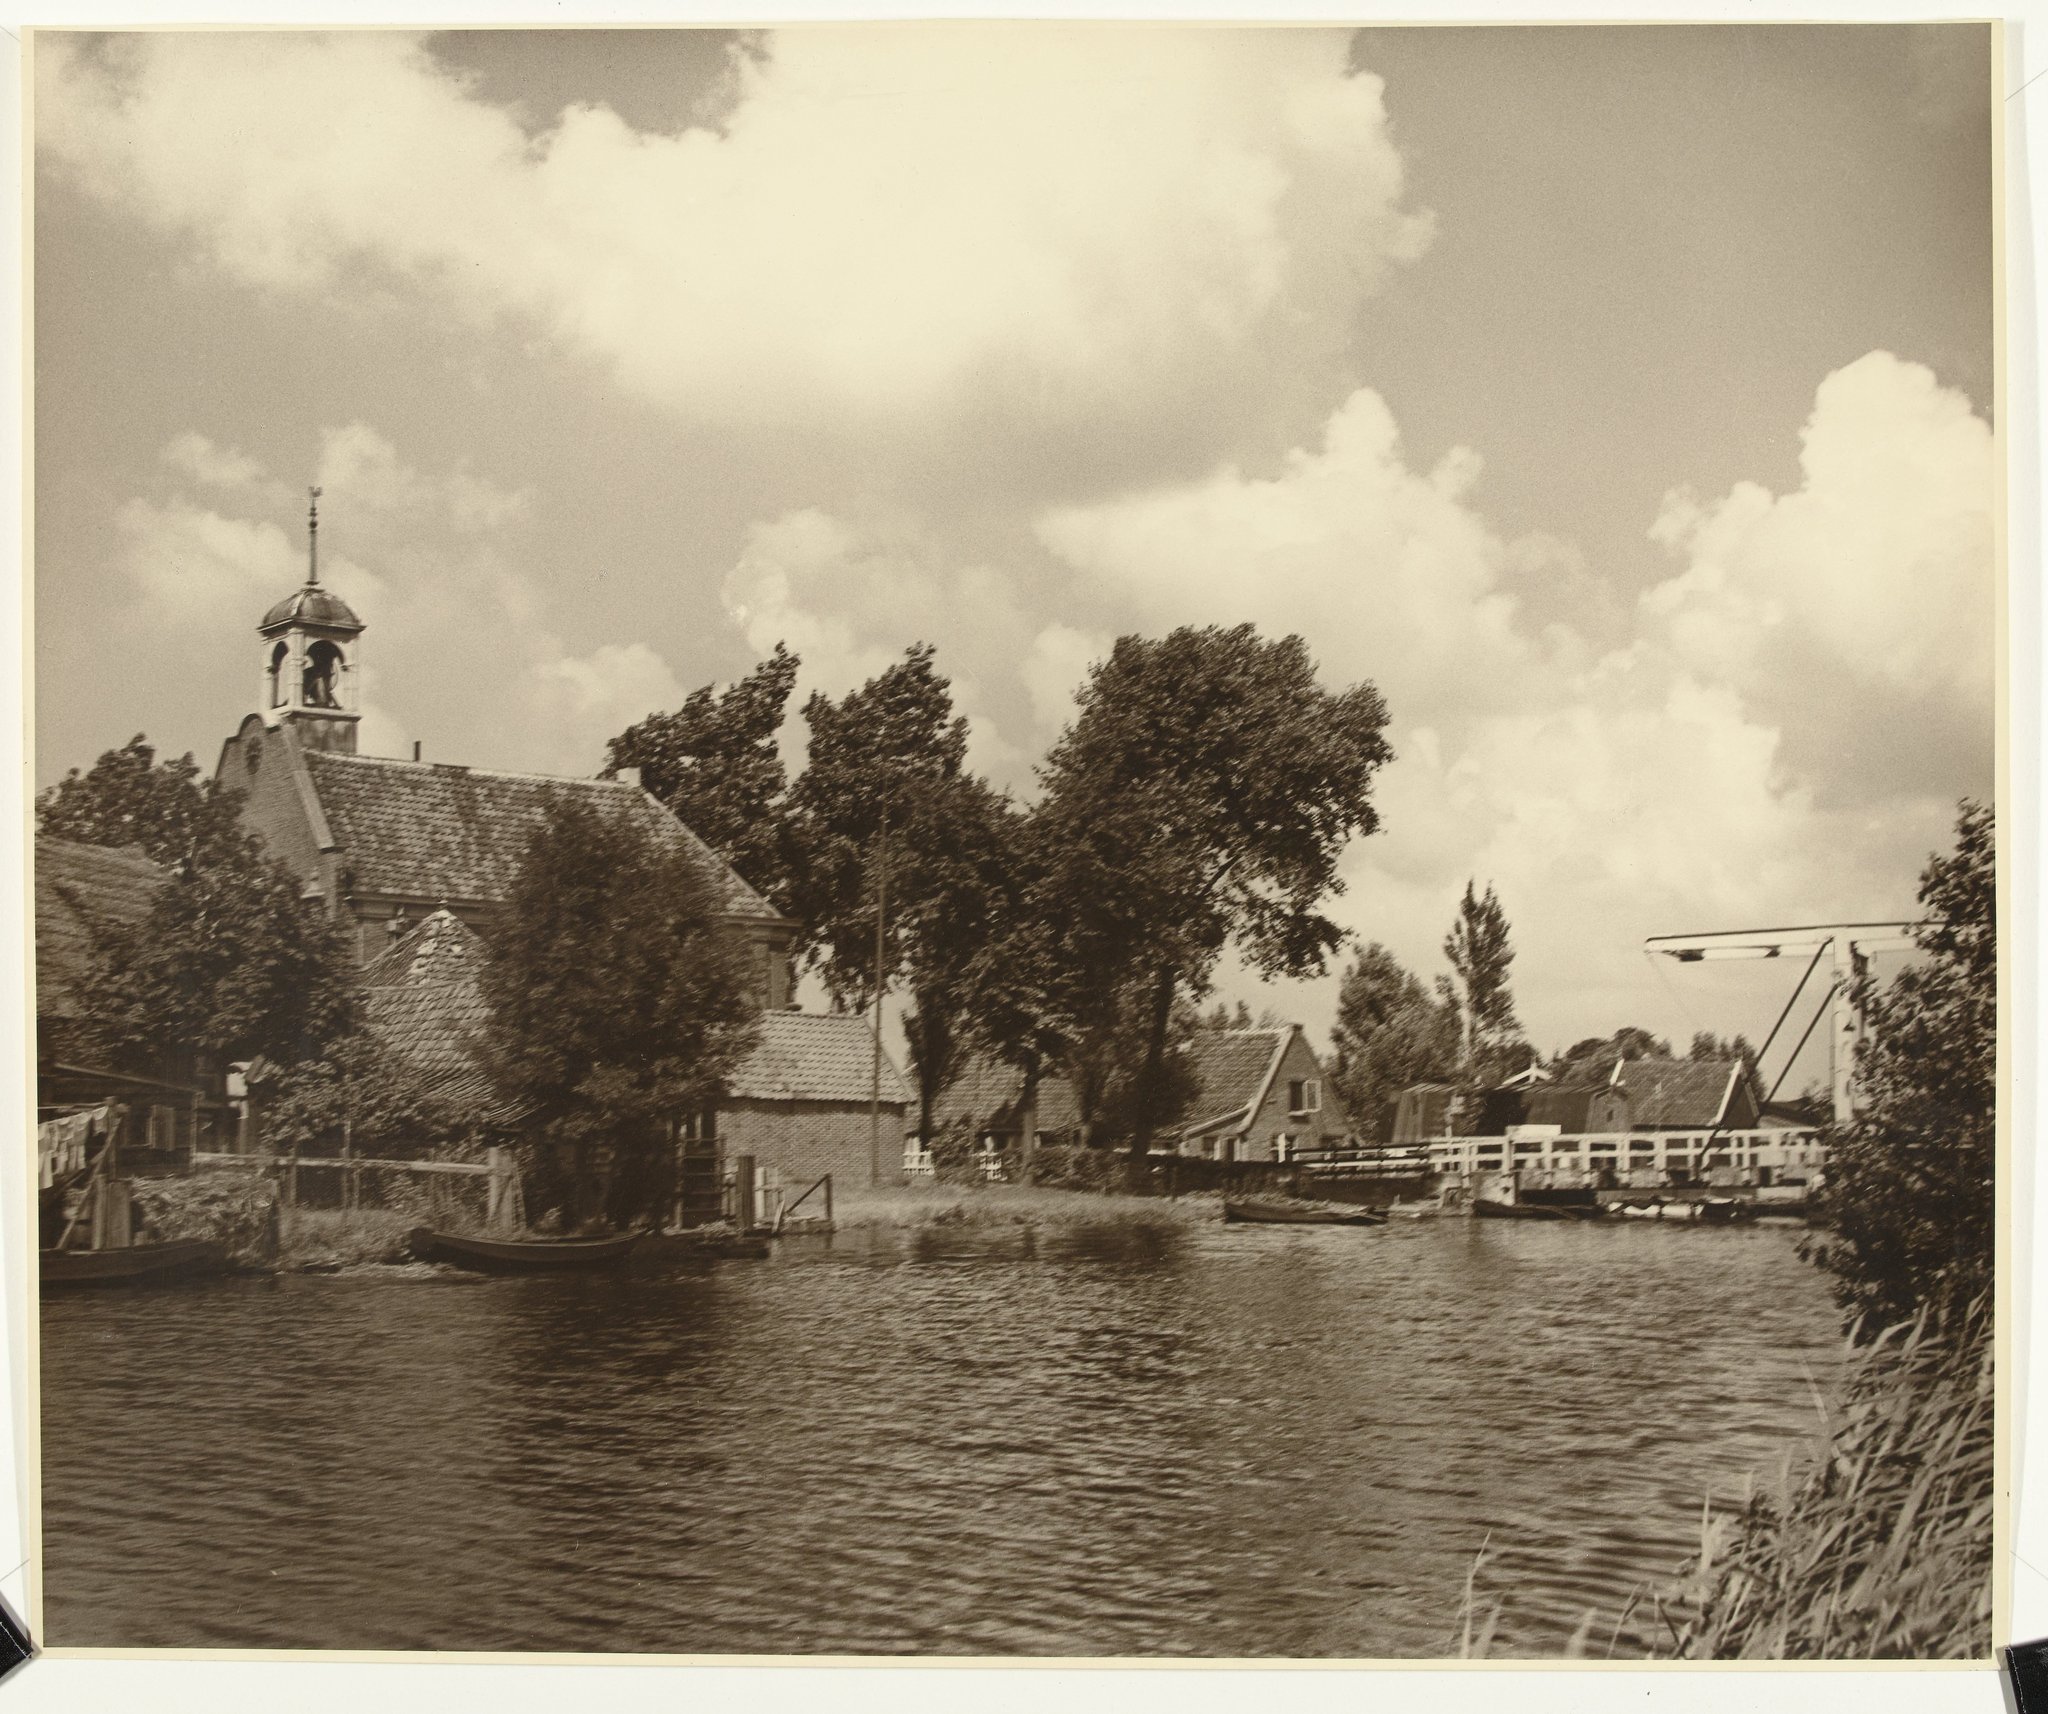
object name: photograph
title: Landschap met vaart, kerk en ophaalbrug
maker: Anonymous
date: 1920-1940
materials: photographic support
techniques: gelatin silver print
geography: netherlands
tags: canals, waters (in village)